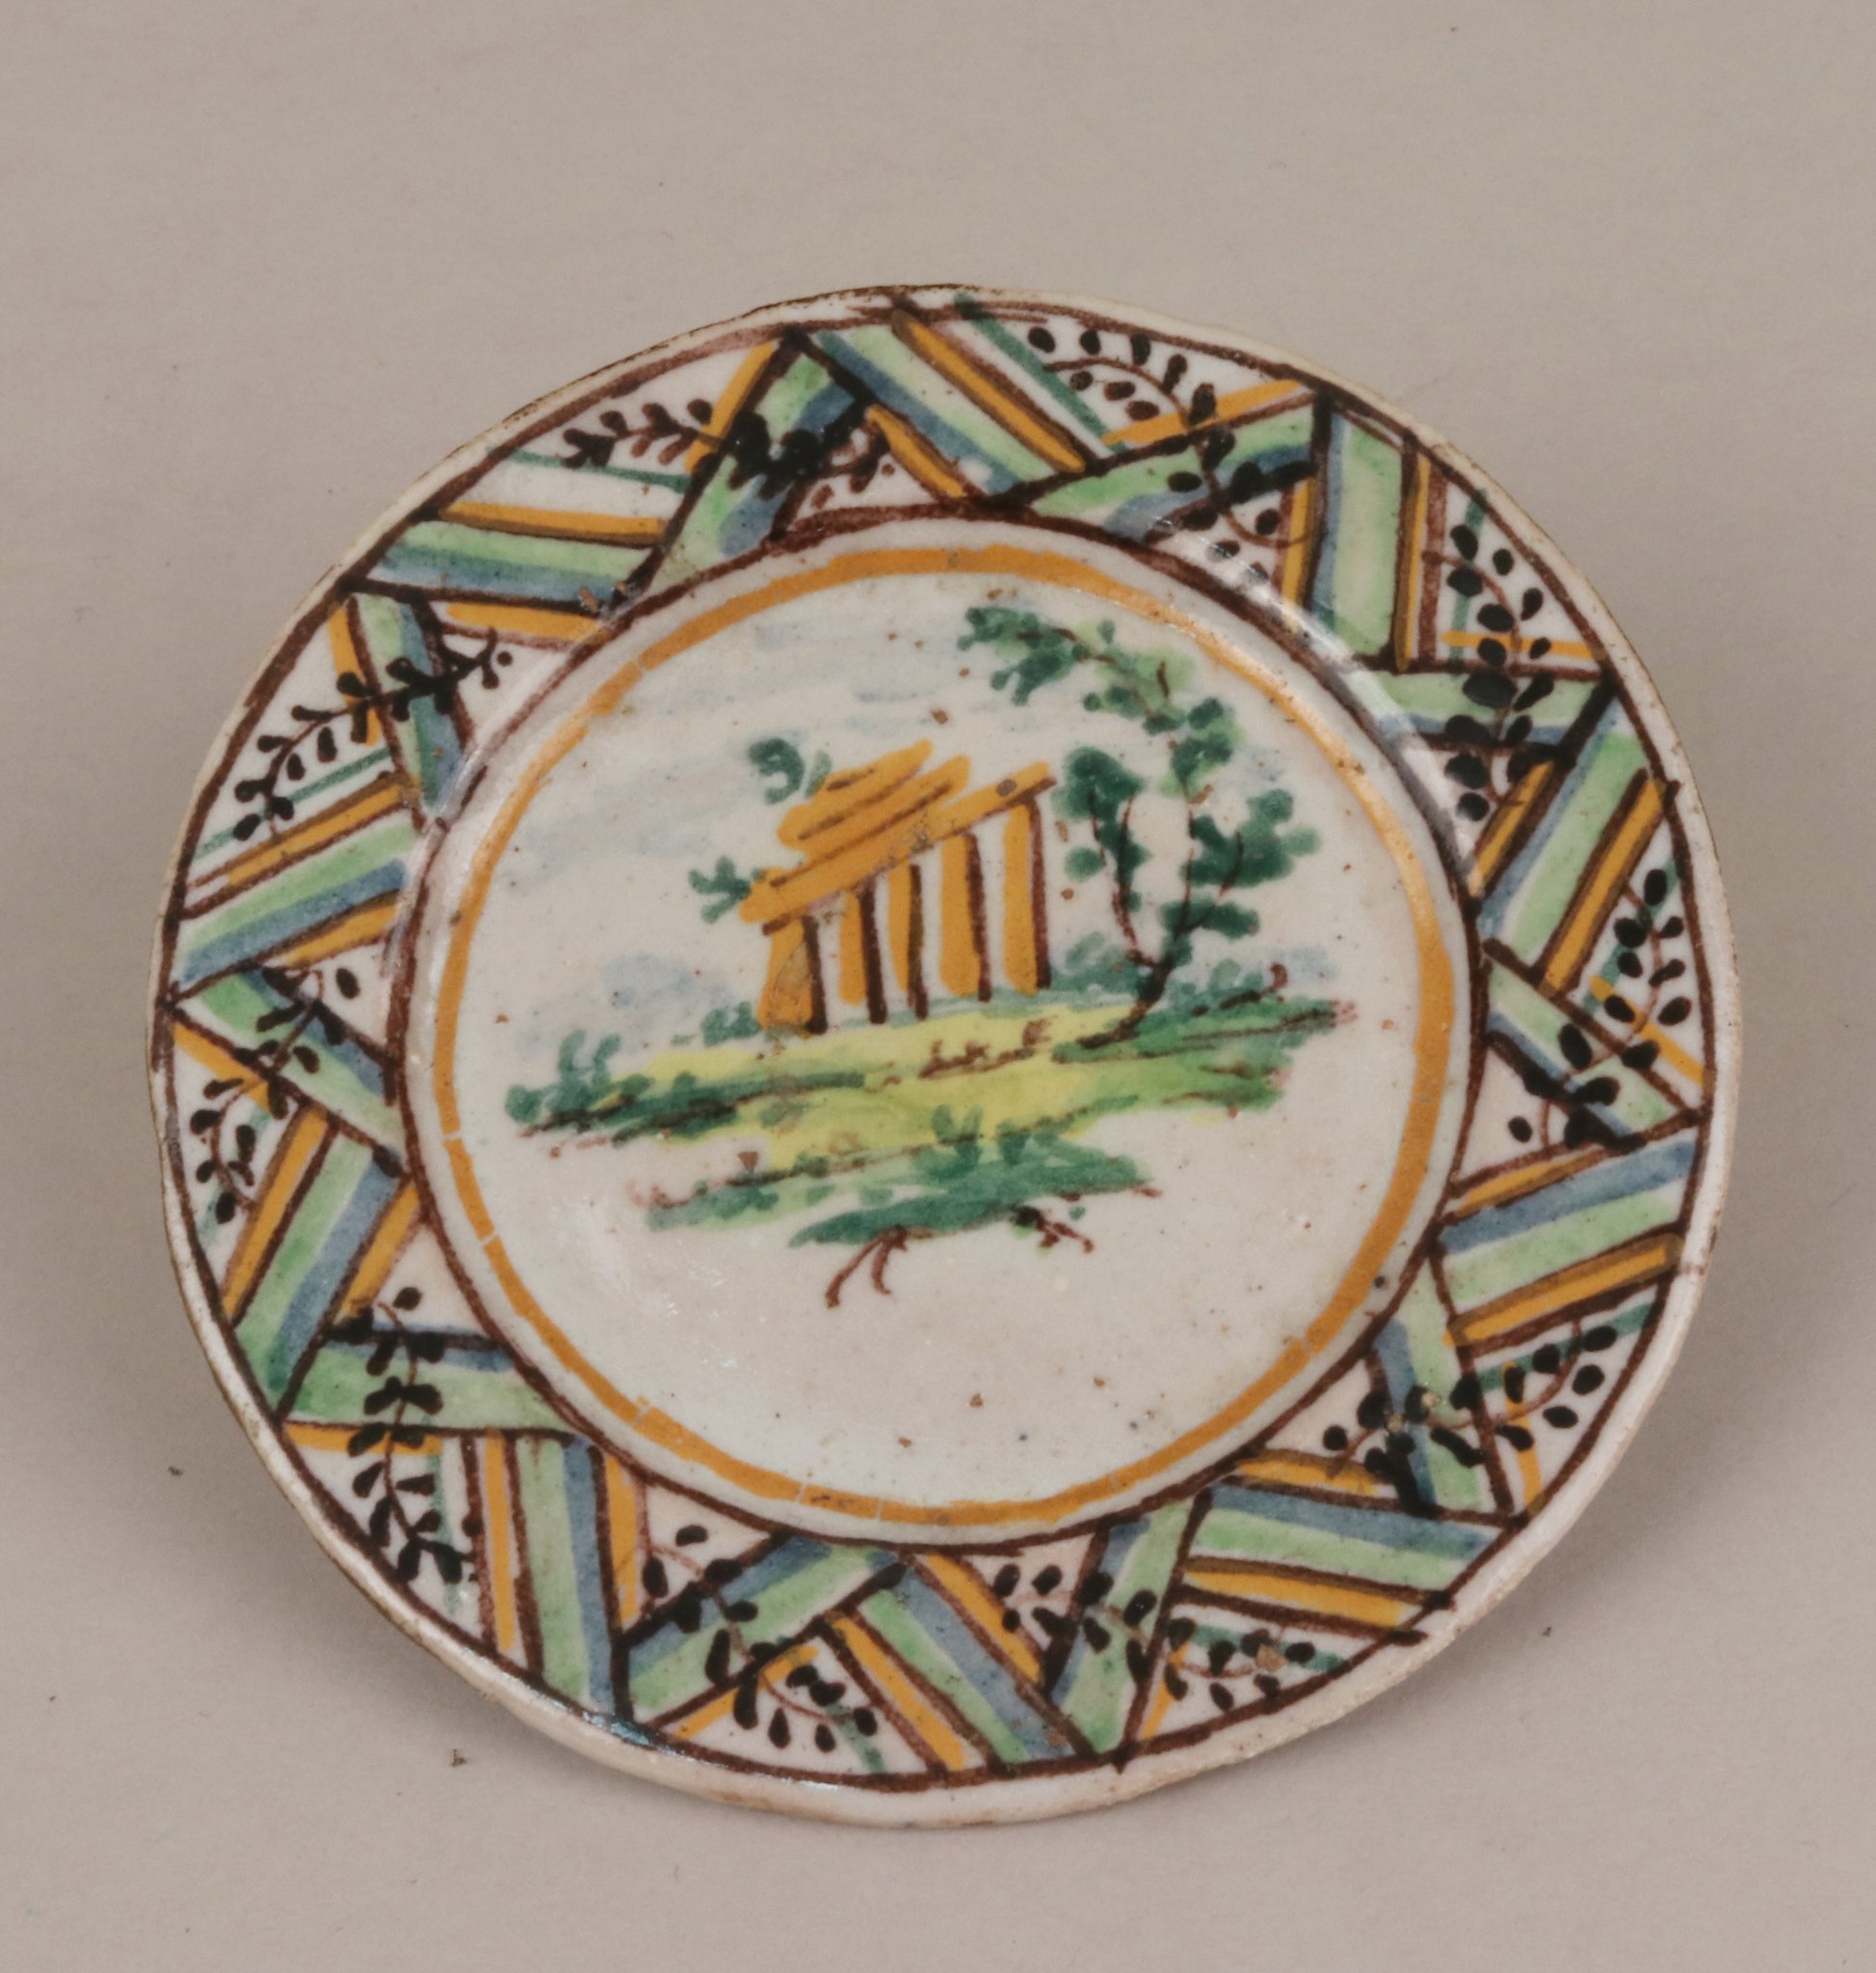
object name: crèche accessory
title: Plate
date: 1701-1800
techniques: maiolica, glazing